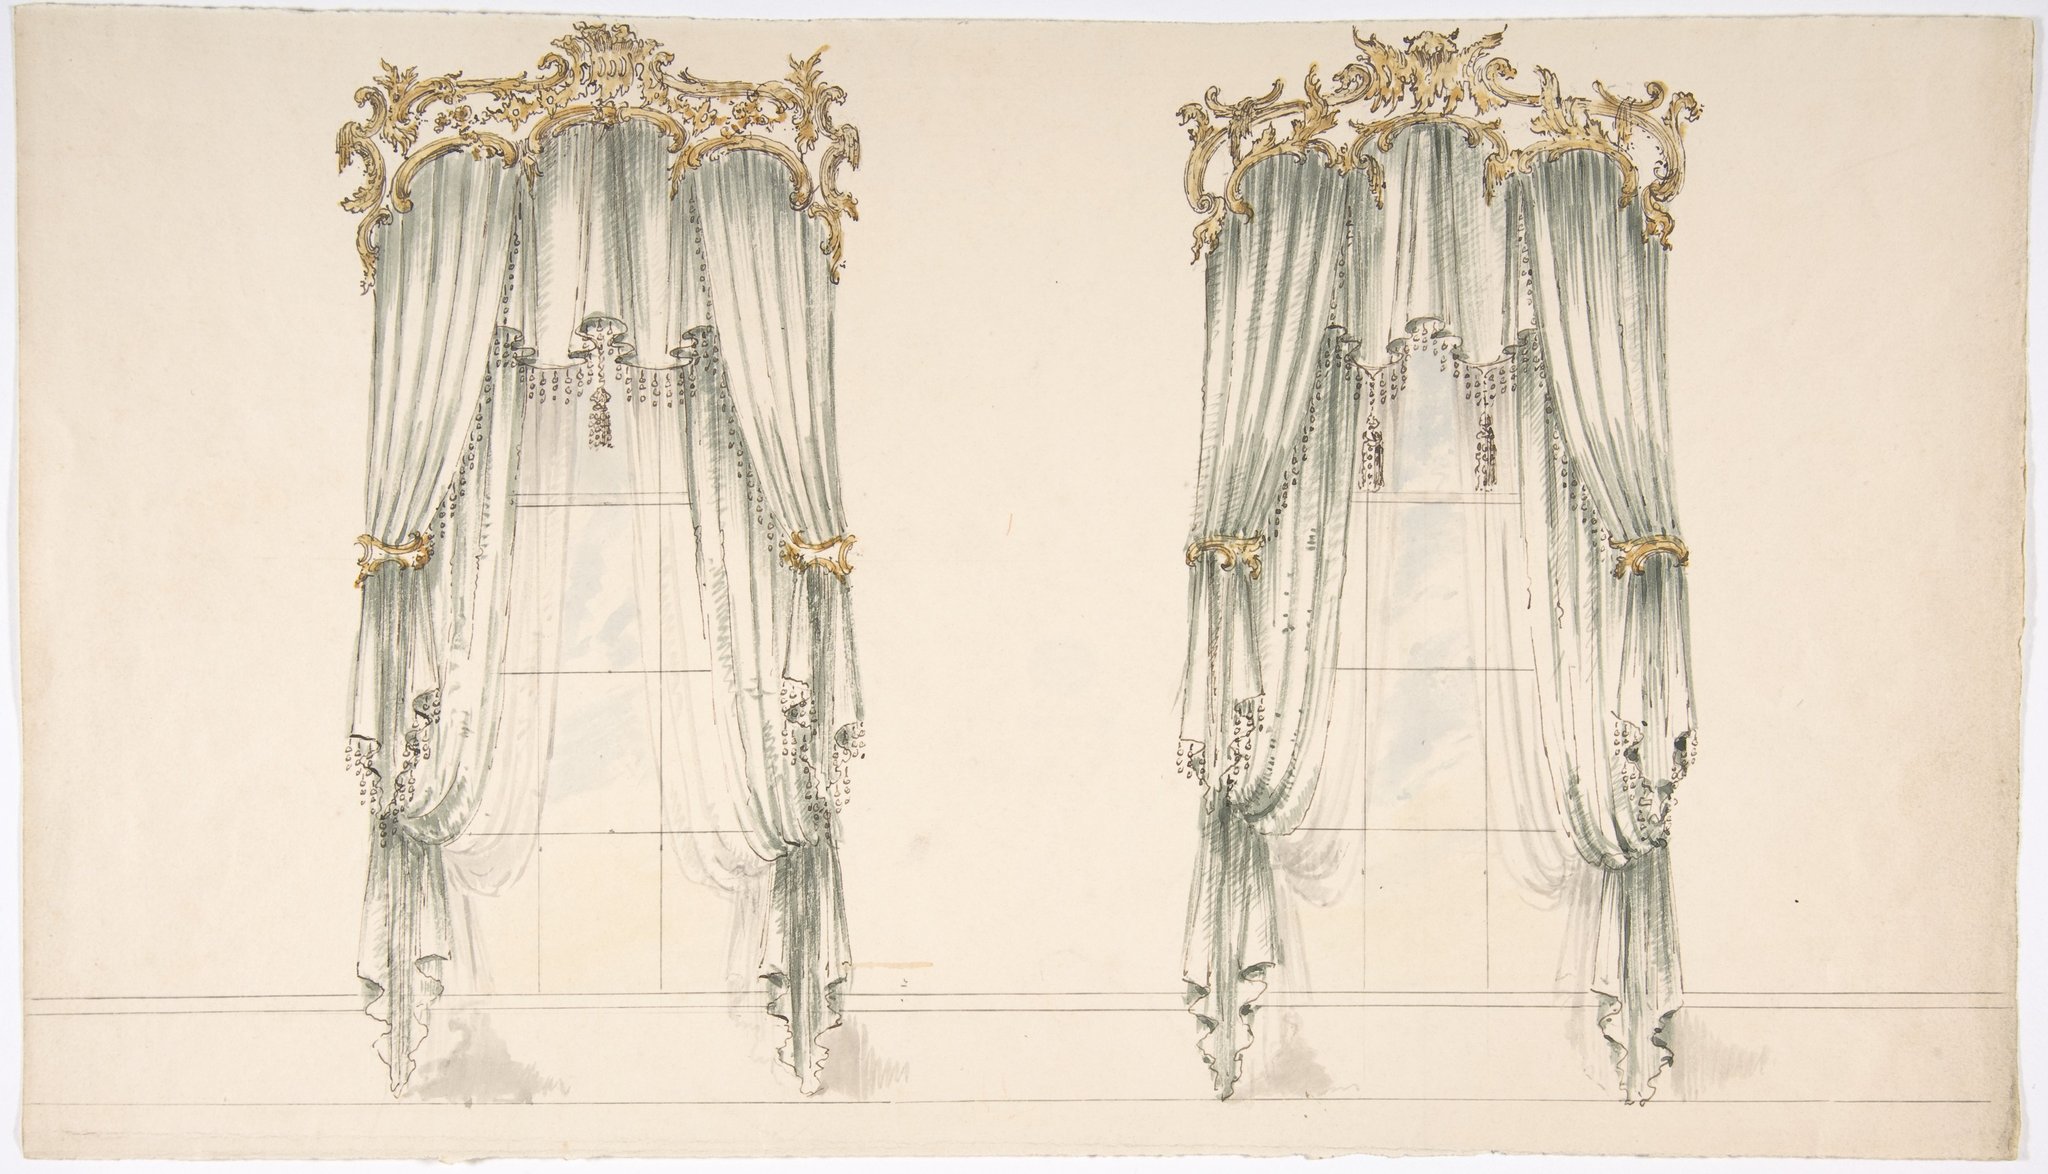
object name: drawing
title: Design for White Curtains with White Fringes and a Gold and White Pediment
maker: anonymous, british, 19th century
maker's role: artist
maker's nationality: british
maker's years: 1800-1900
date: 1801-1833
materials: ink, watercolor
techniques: brush, pen, wash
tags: architecture,curtains